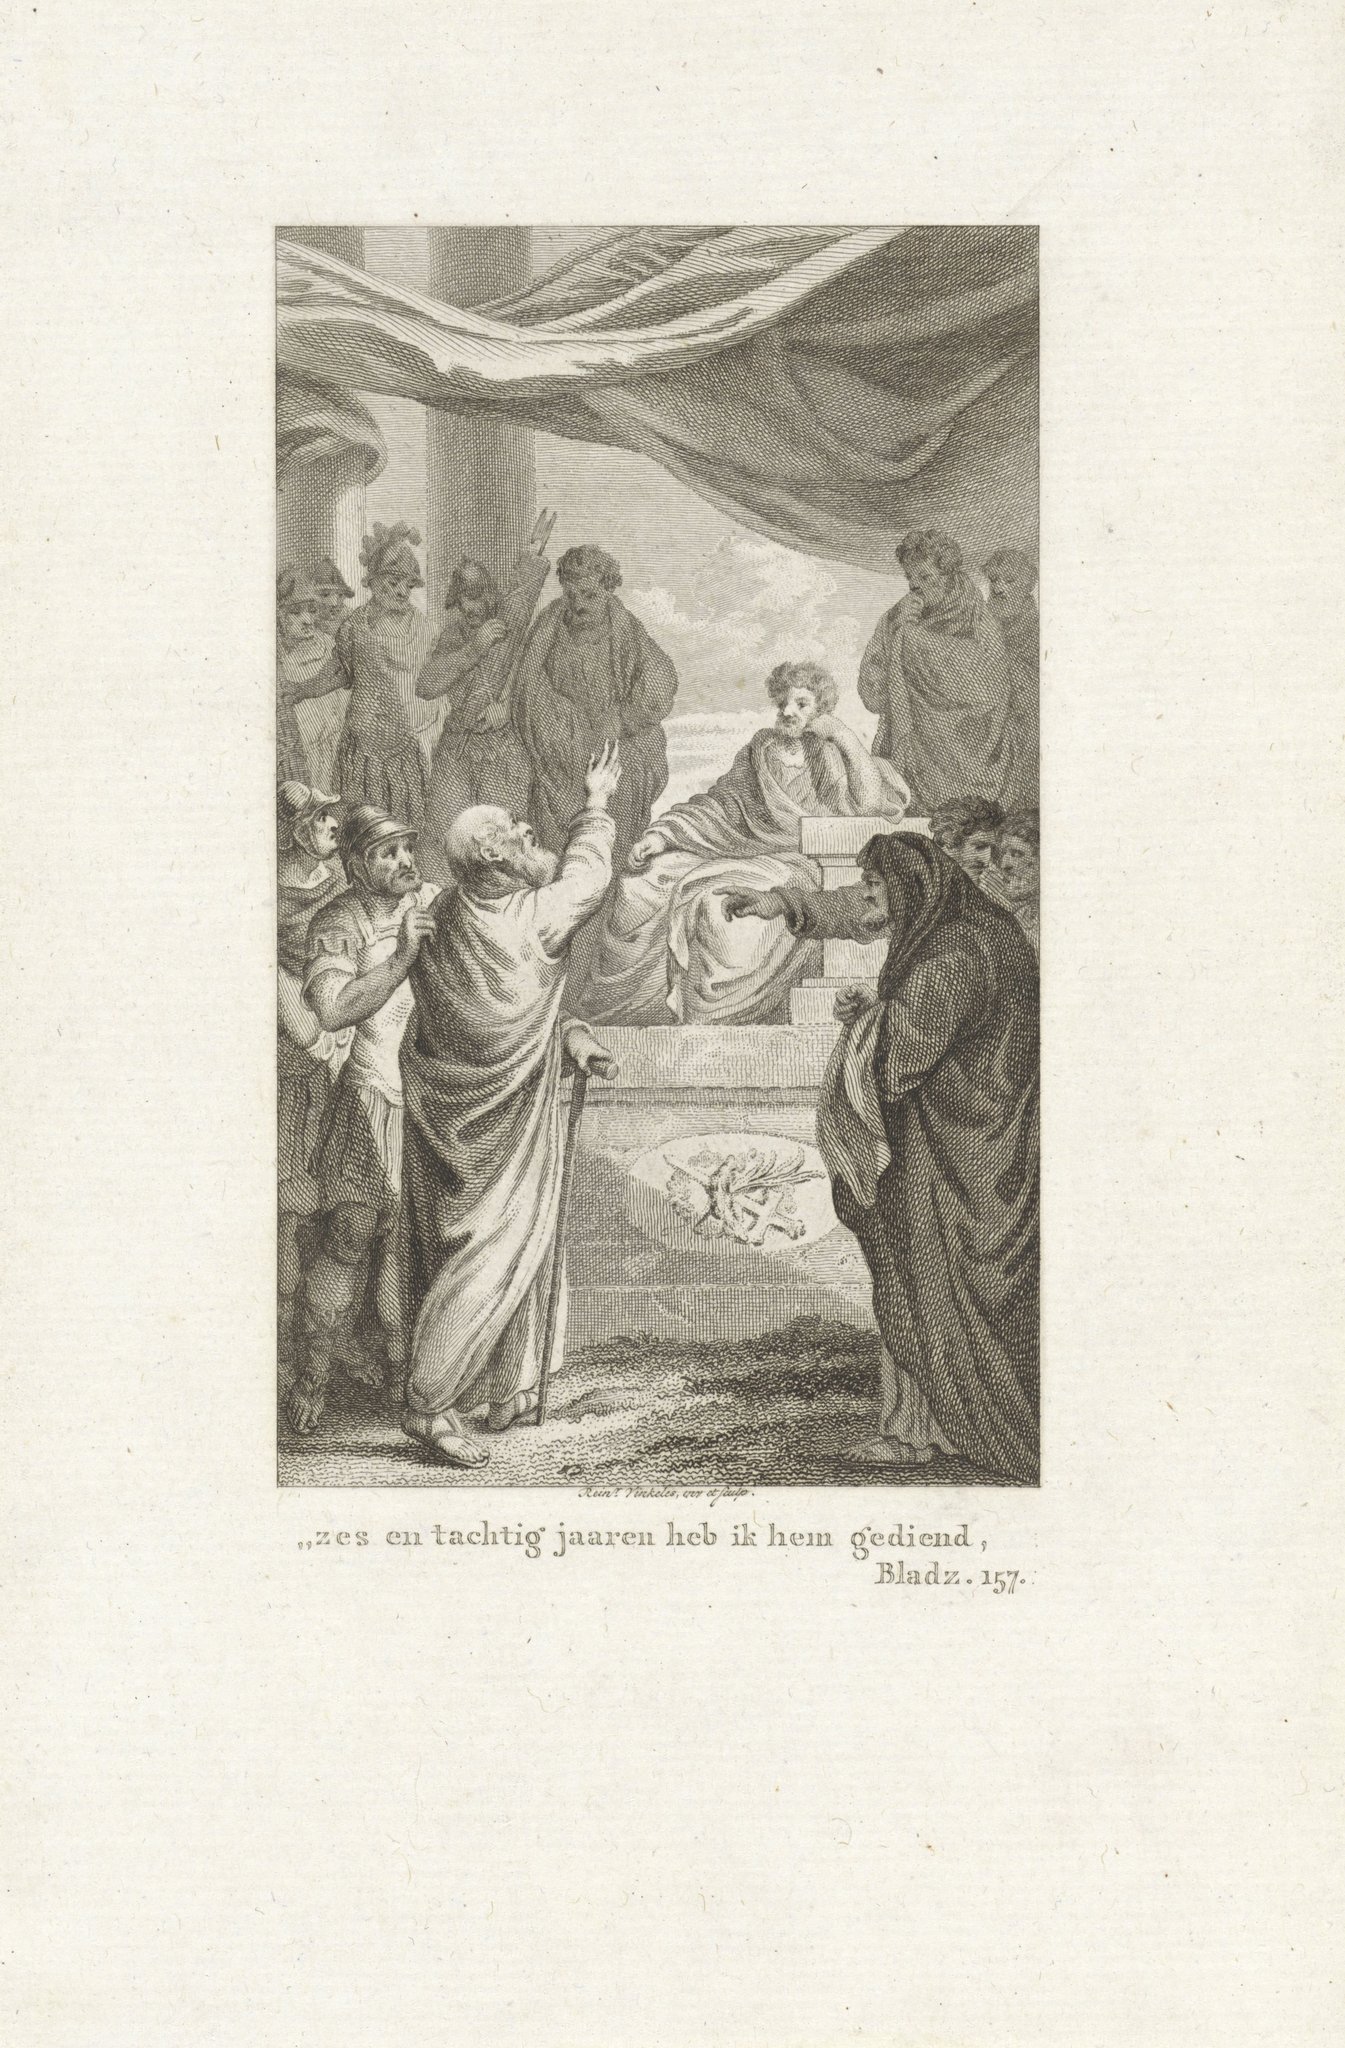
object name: print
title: zes en tachtig jaaren heb ik hem gediend,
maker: reinier vinkeles (i)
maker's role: draughtsman, print maker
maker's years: 1741-1816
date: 1800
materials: paper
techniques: engraving, etching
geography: amsterdam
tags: juridical examples; exemplary judges; 'gerechtigkeitsbilder' (+ judge)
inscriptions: collector's mark: Lugt 240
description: Illustratie in: Hamelsveld, Ysbrand van. Algemeene kerkelijke geschiedenis, der Christenen, deel 2. Haarlem: François Bohn, 1800, p. 157.